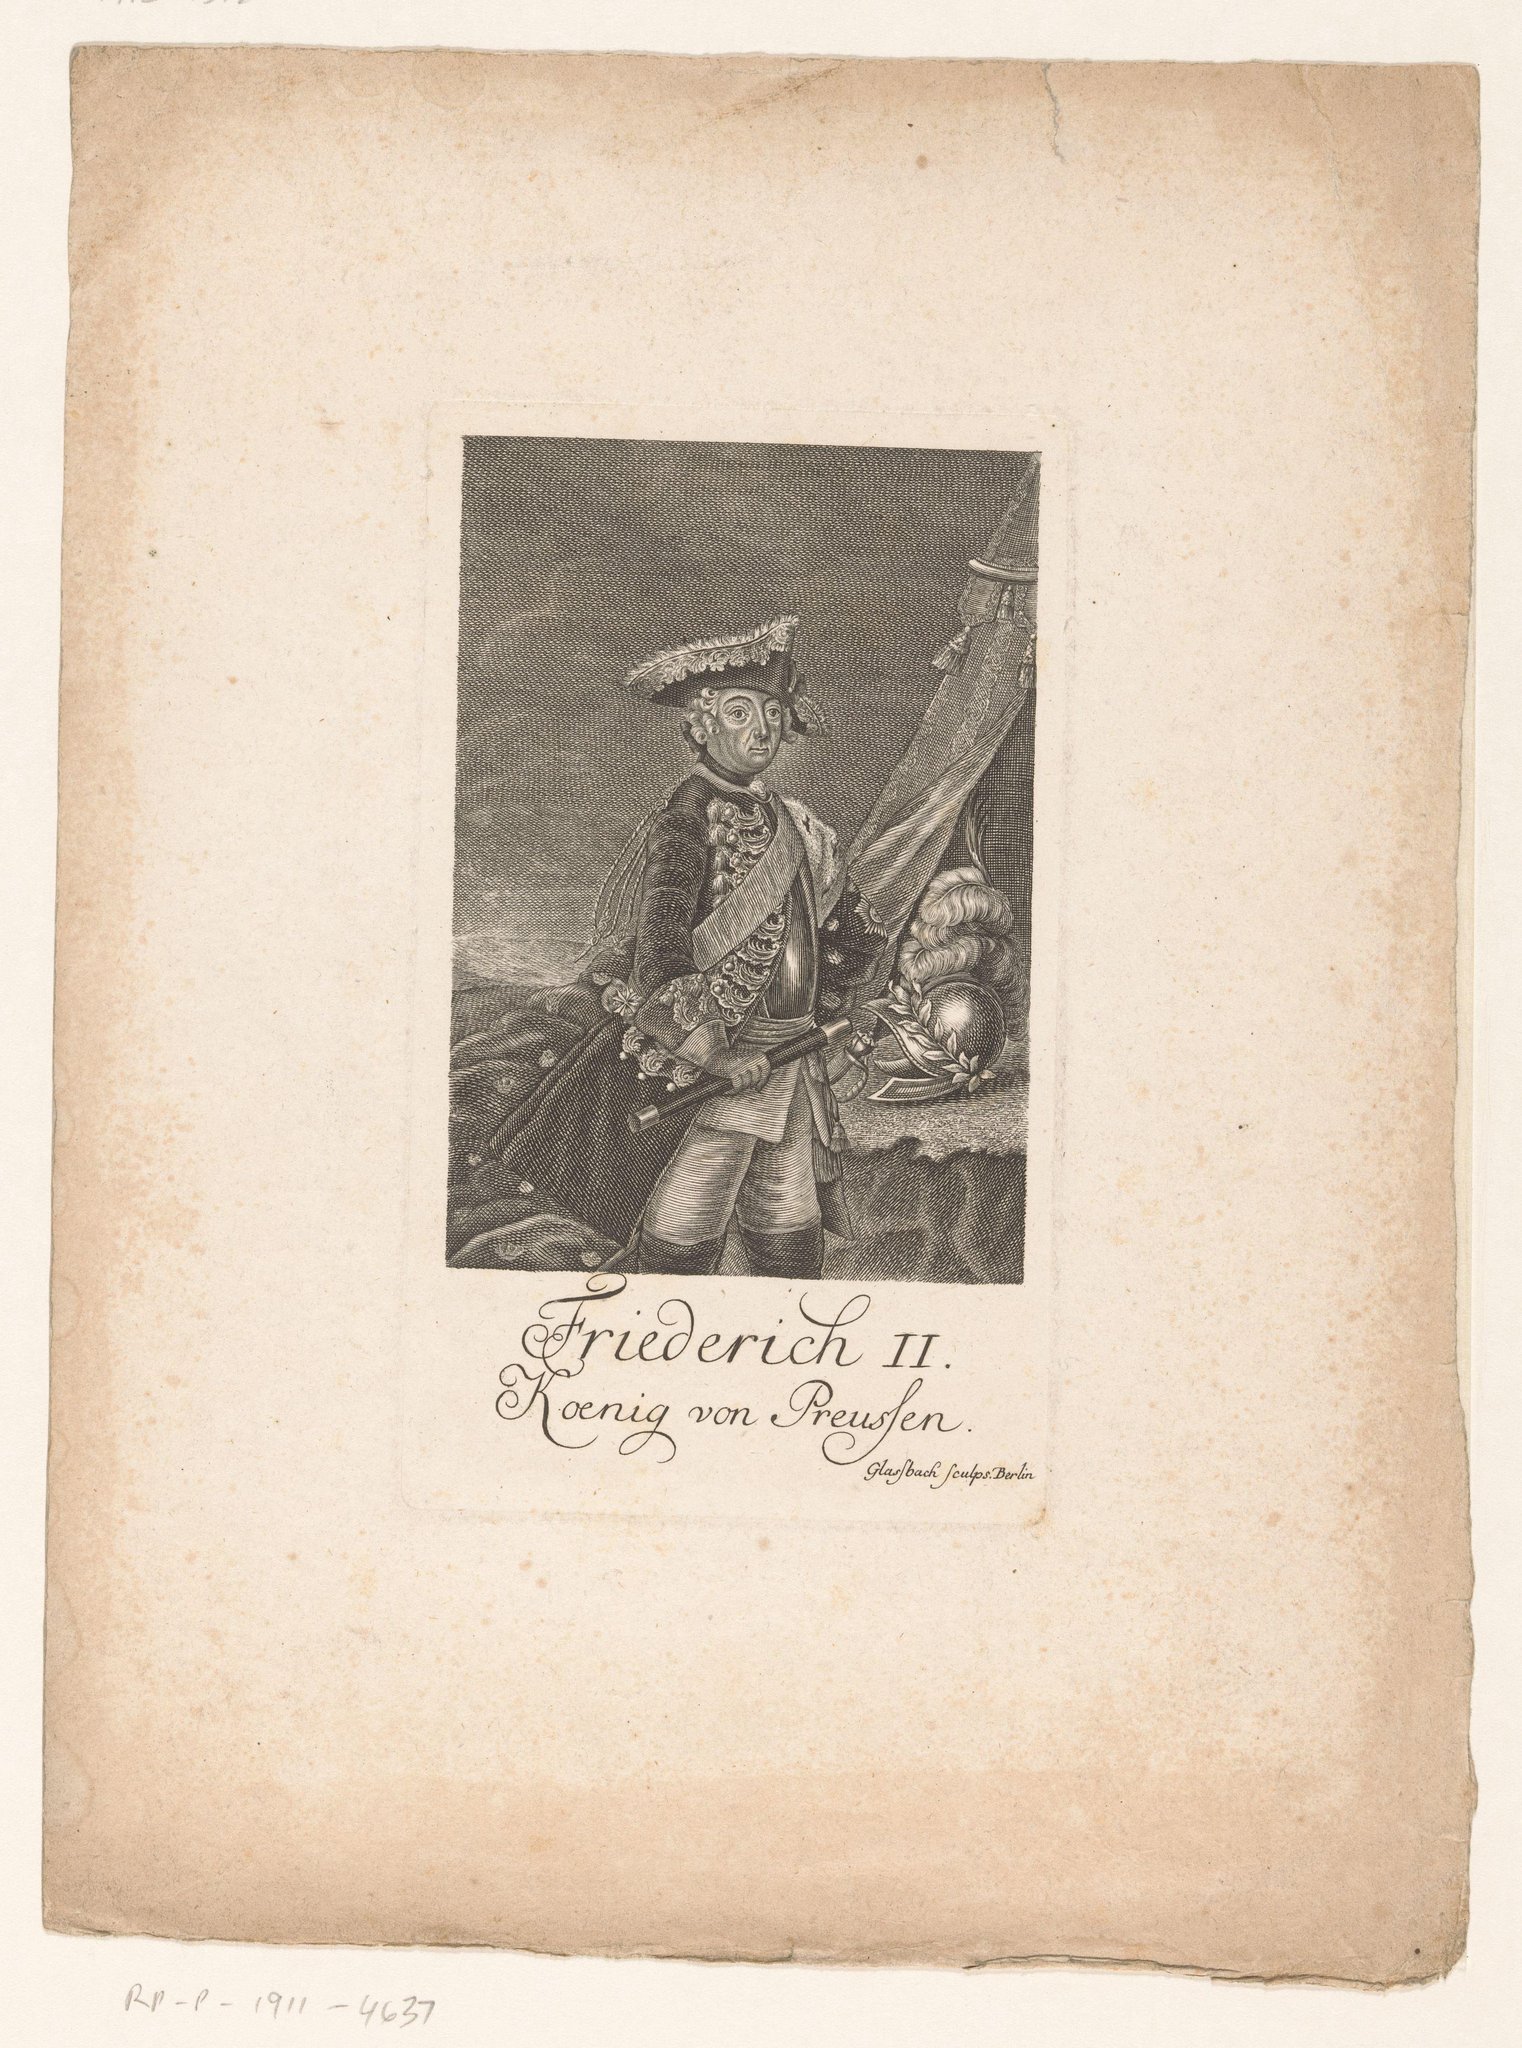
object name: print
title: Portret van Frederik de Grote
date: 1734-1779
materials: paper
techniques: engraving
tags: berlin, frederick ii (king of prussia), helmet, historical persons, ruler, sovereign, baton of general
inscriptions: collector's mark: Lugt 2228